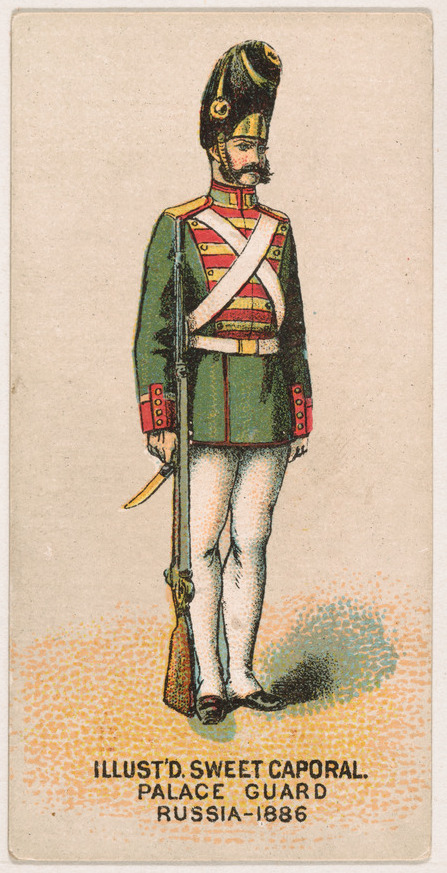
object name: print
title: Palace Guard, Russia, 1886, from the Military Series (N224) issued by Kinney Tobacco Company to promote Sweet Caporal Cigarettes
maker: kinney brothers tobacco company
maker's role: publisher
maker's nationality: american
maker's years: 1869-2011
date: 1888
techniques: color lithograph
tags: soldiers,men